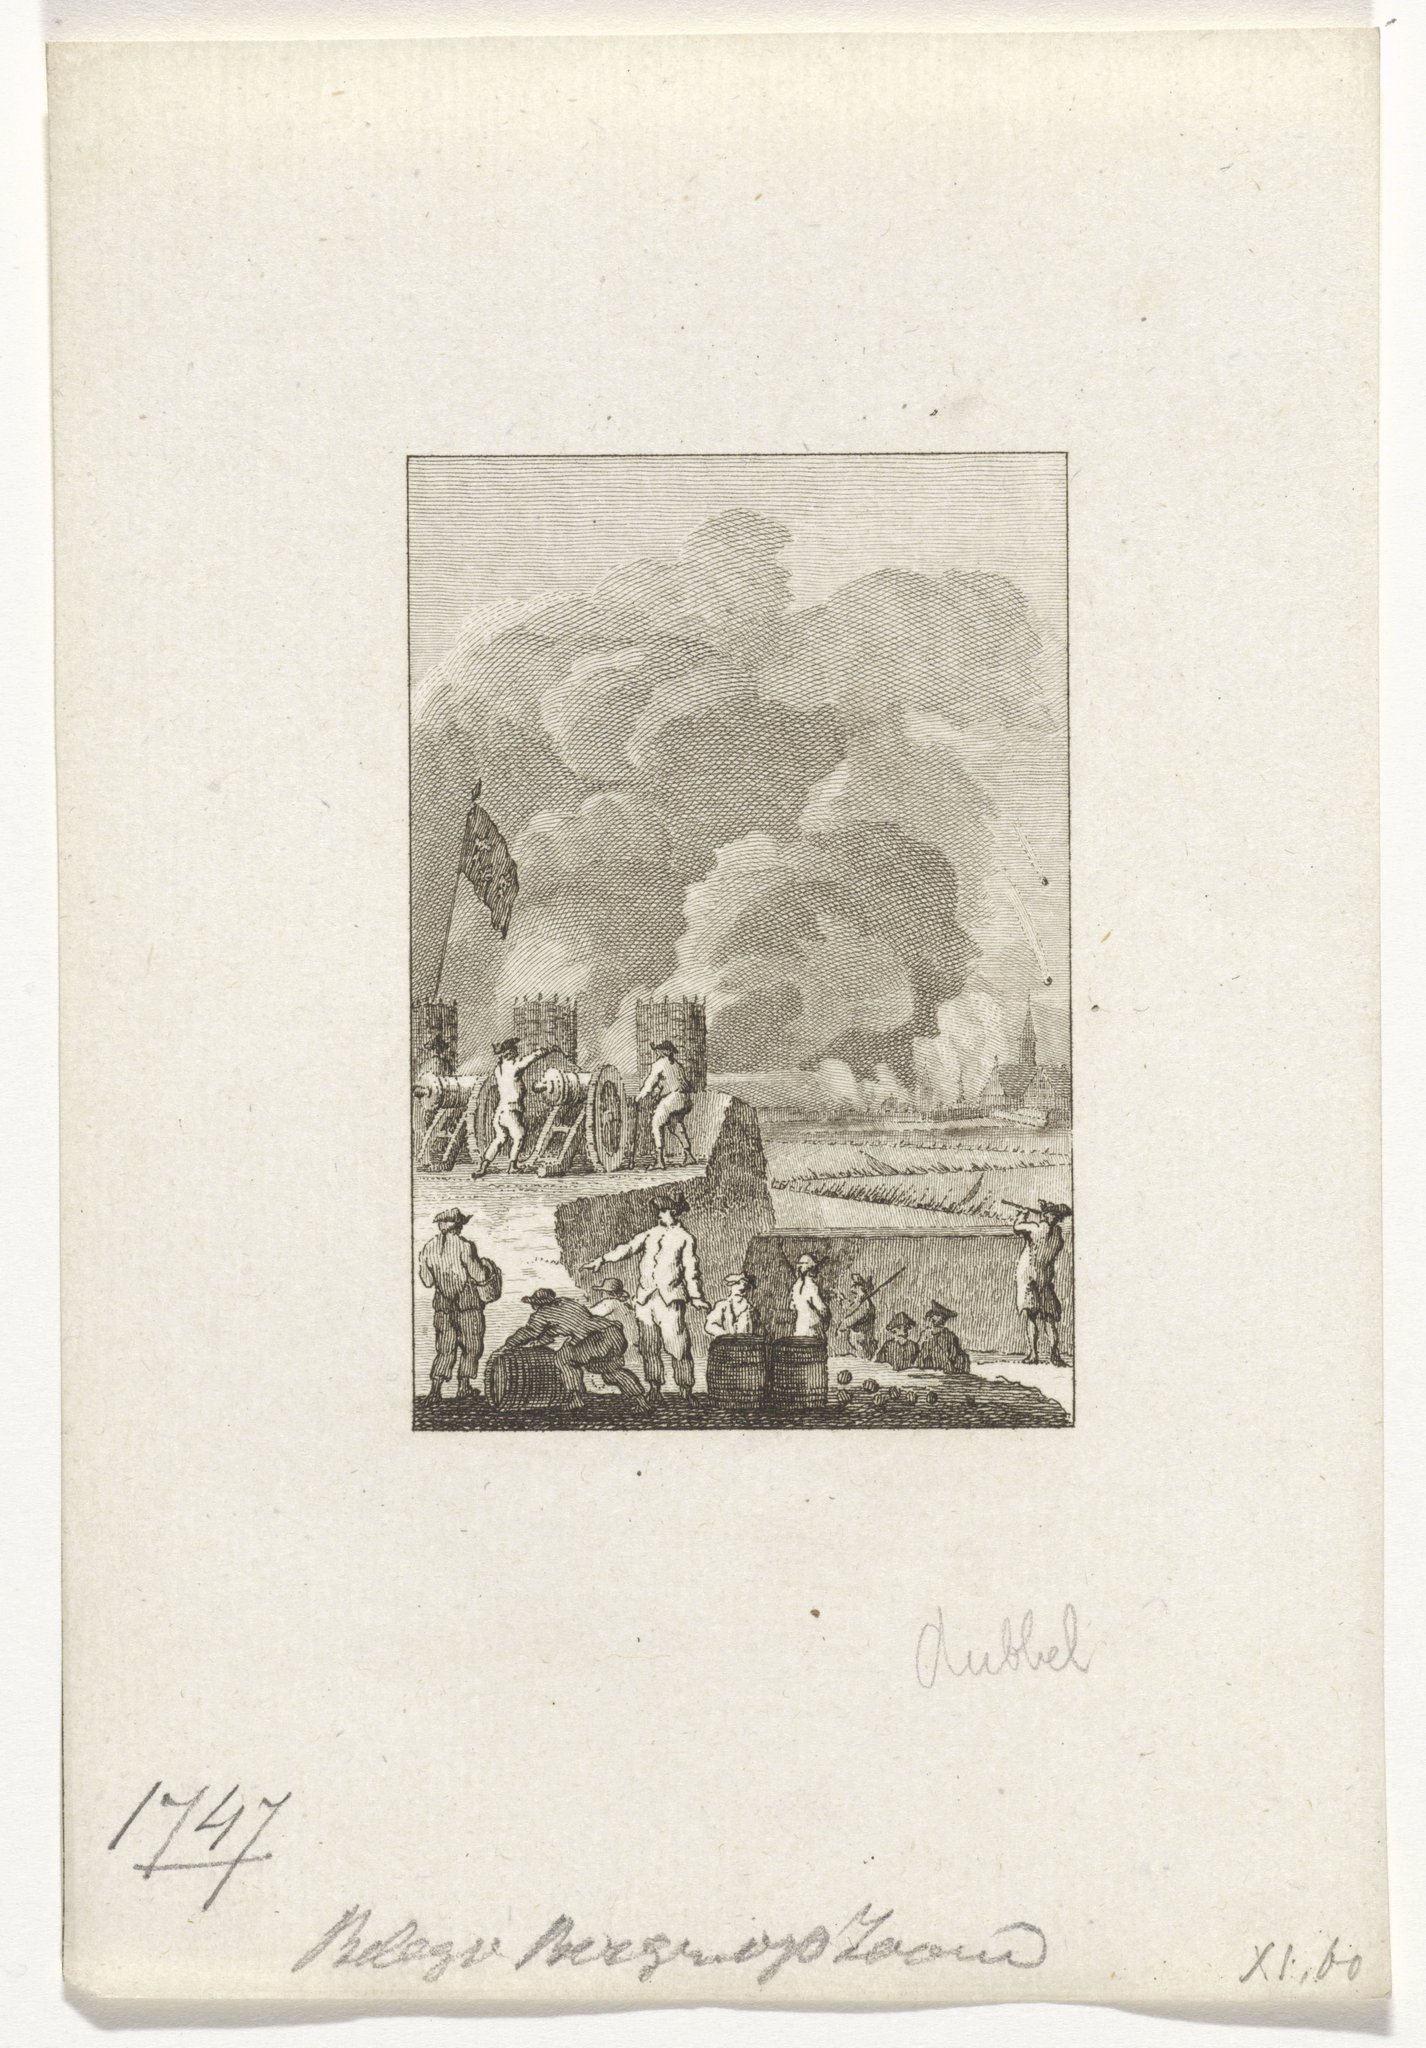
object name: print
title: Beleg van Bergen op Zoom, 1747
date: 1783-1795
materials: paper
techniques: etching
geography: amsterdam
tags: siege, position war, bergen op zoom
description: Illustratie voor: J. Fokke. Geschiedenissen der Vereenigde Nederlanden voor de vaderlandsche jeugd. Amsterdam: Johannes Allart, 1783-1795, 25 delen. deel XI pl. III.